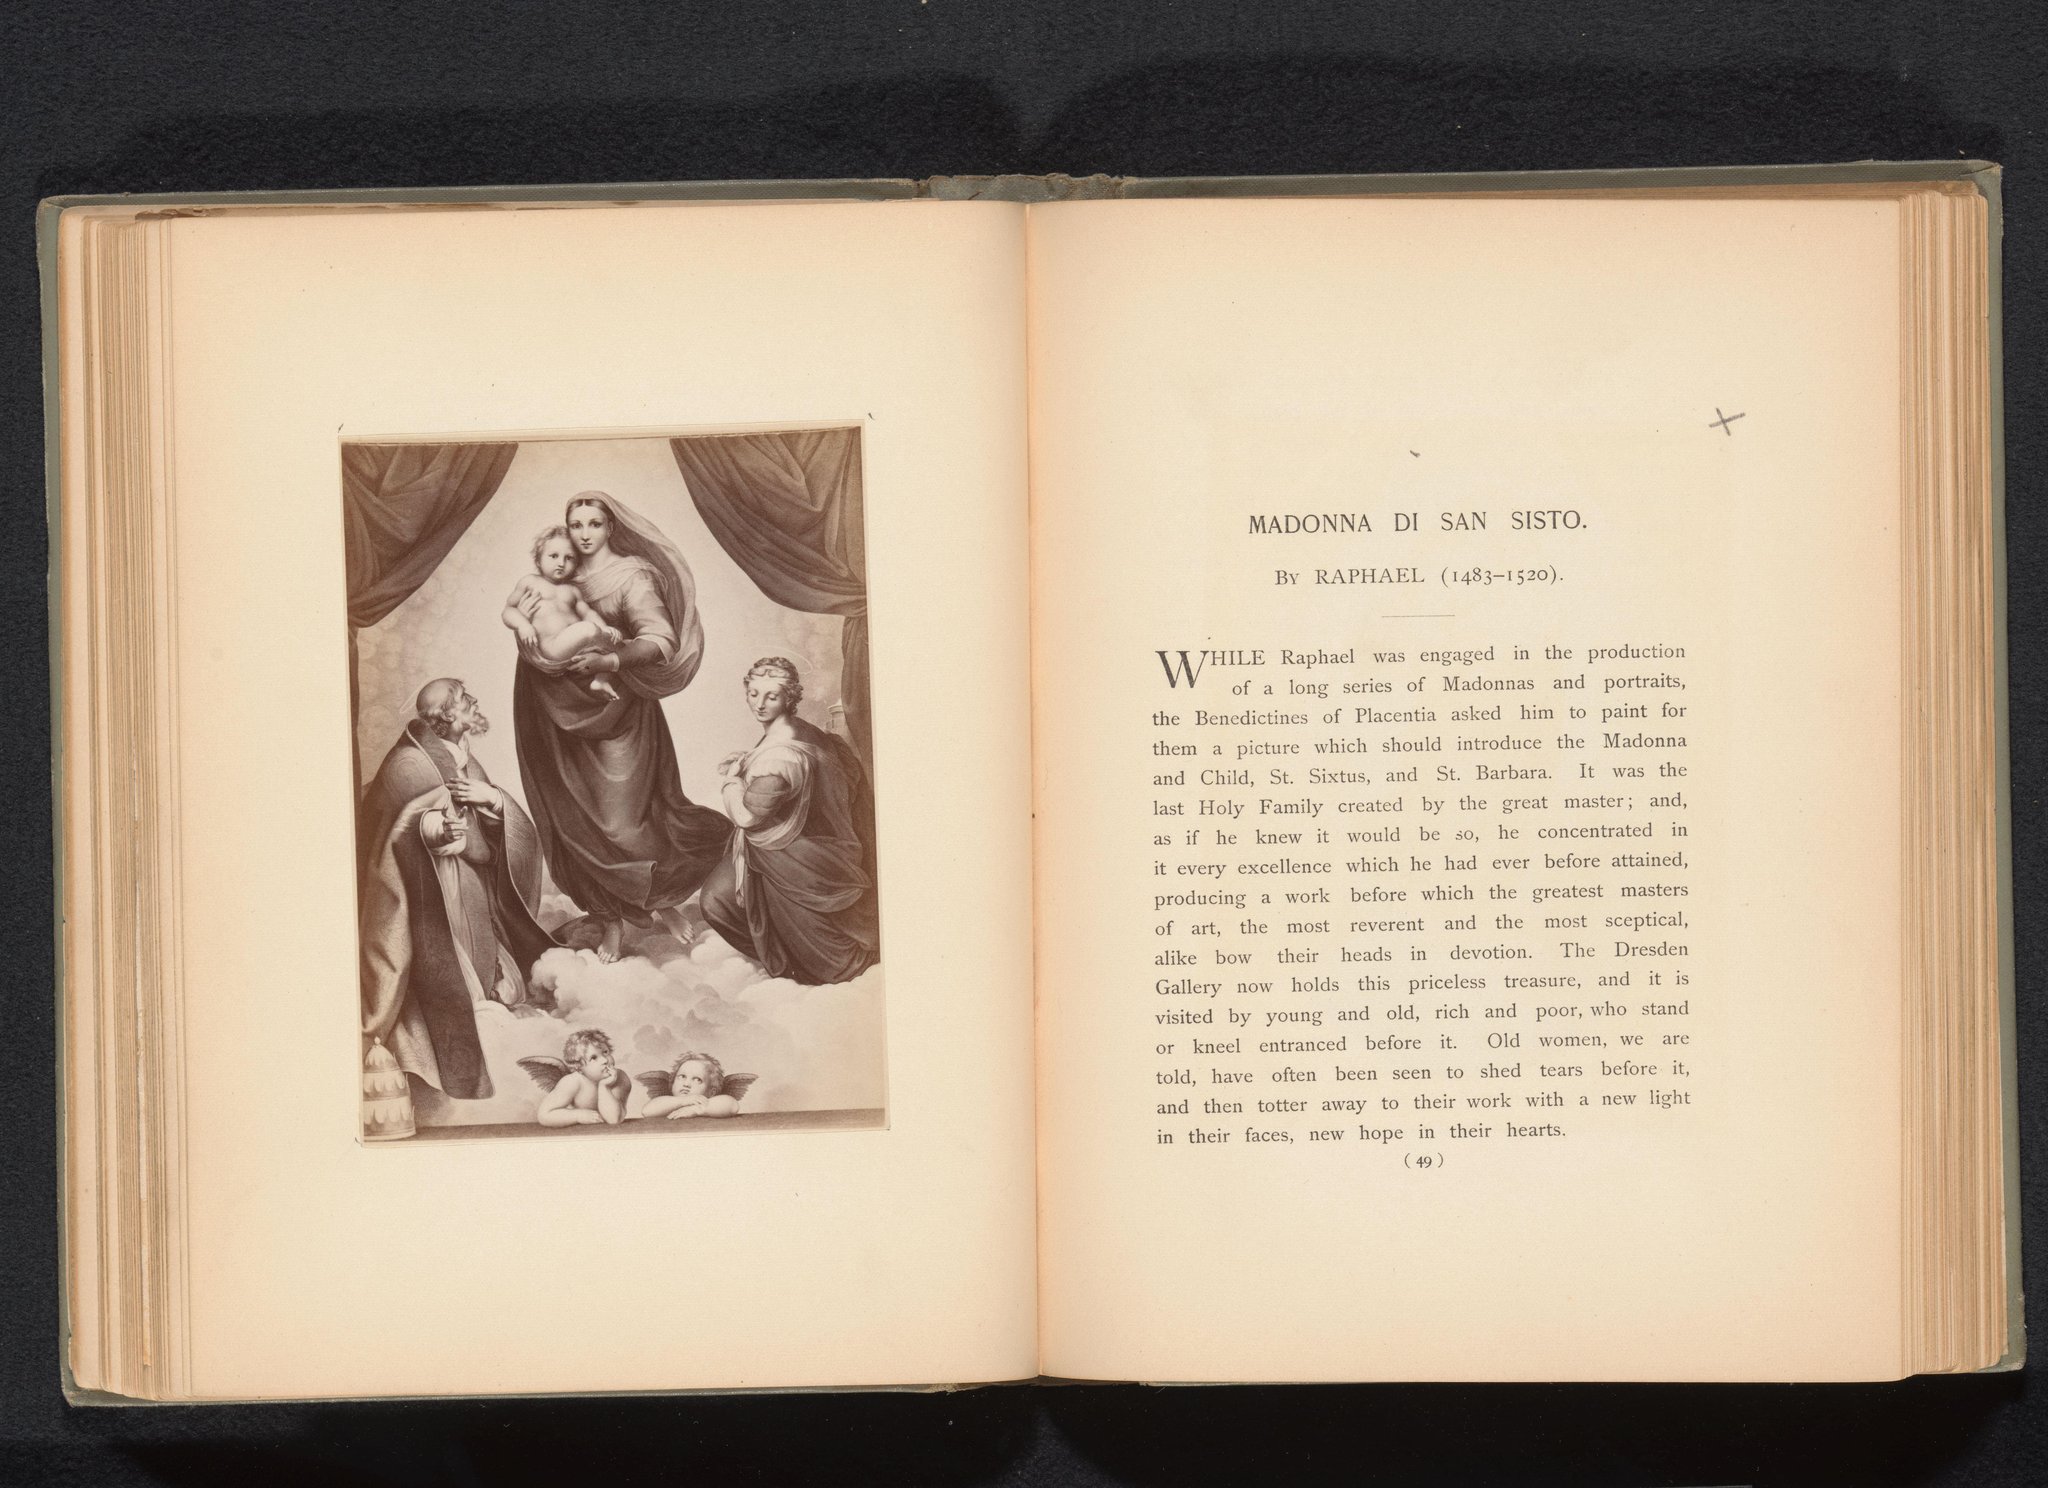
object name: photograph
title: Fotoreproductie van een prent naar een schilderij, voorstellende de Sixtijnse Madonna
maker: Anonymous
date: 1882-1887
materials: photographic support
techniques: albumen print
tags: madonna: i.e. mary with the christ-child